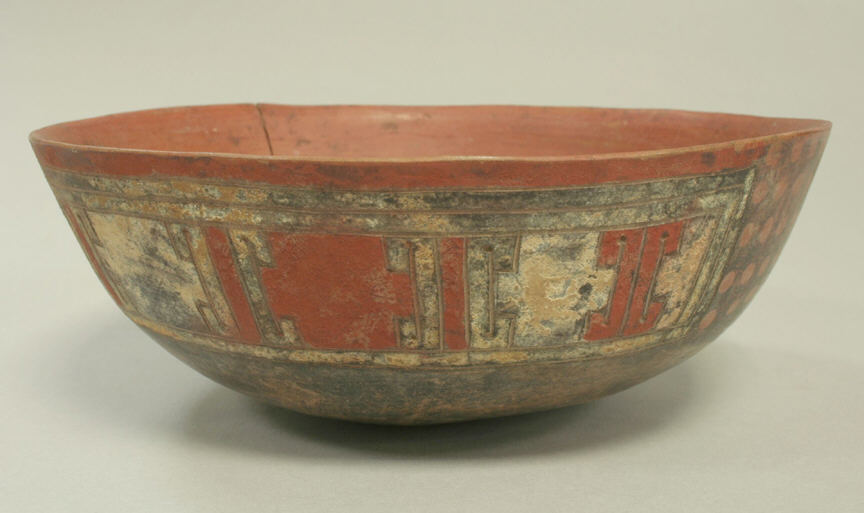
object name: bowl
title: Incised Painted Bowl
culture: paracas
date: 500-101 BCE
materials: ceramic, pigment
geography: peru